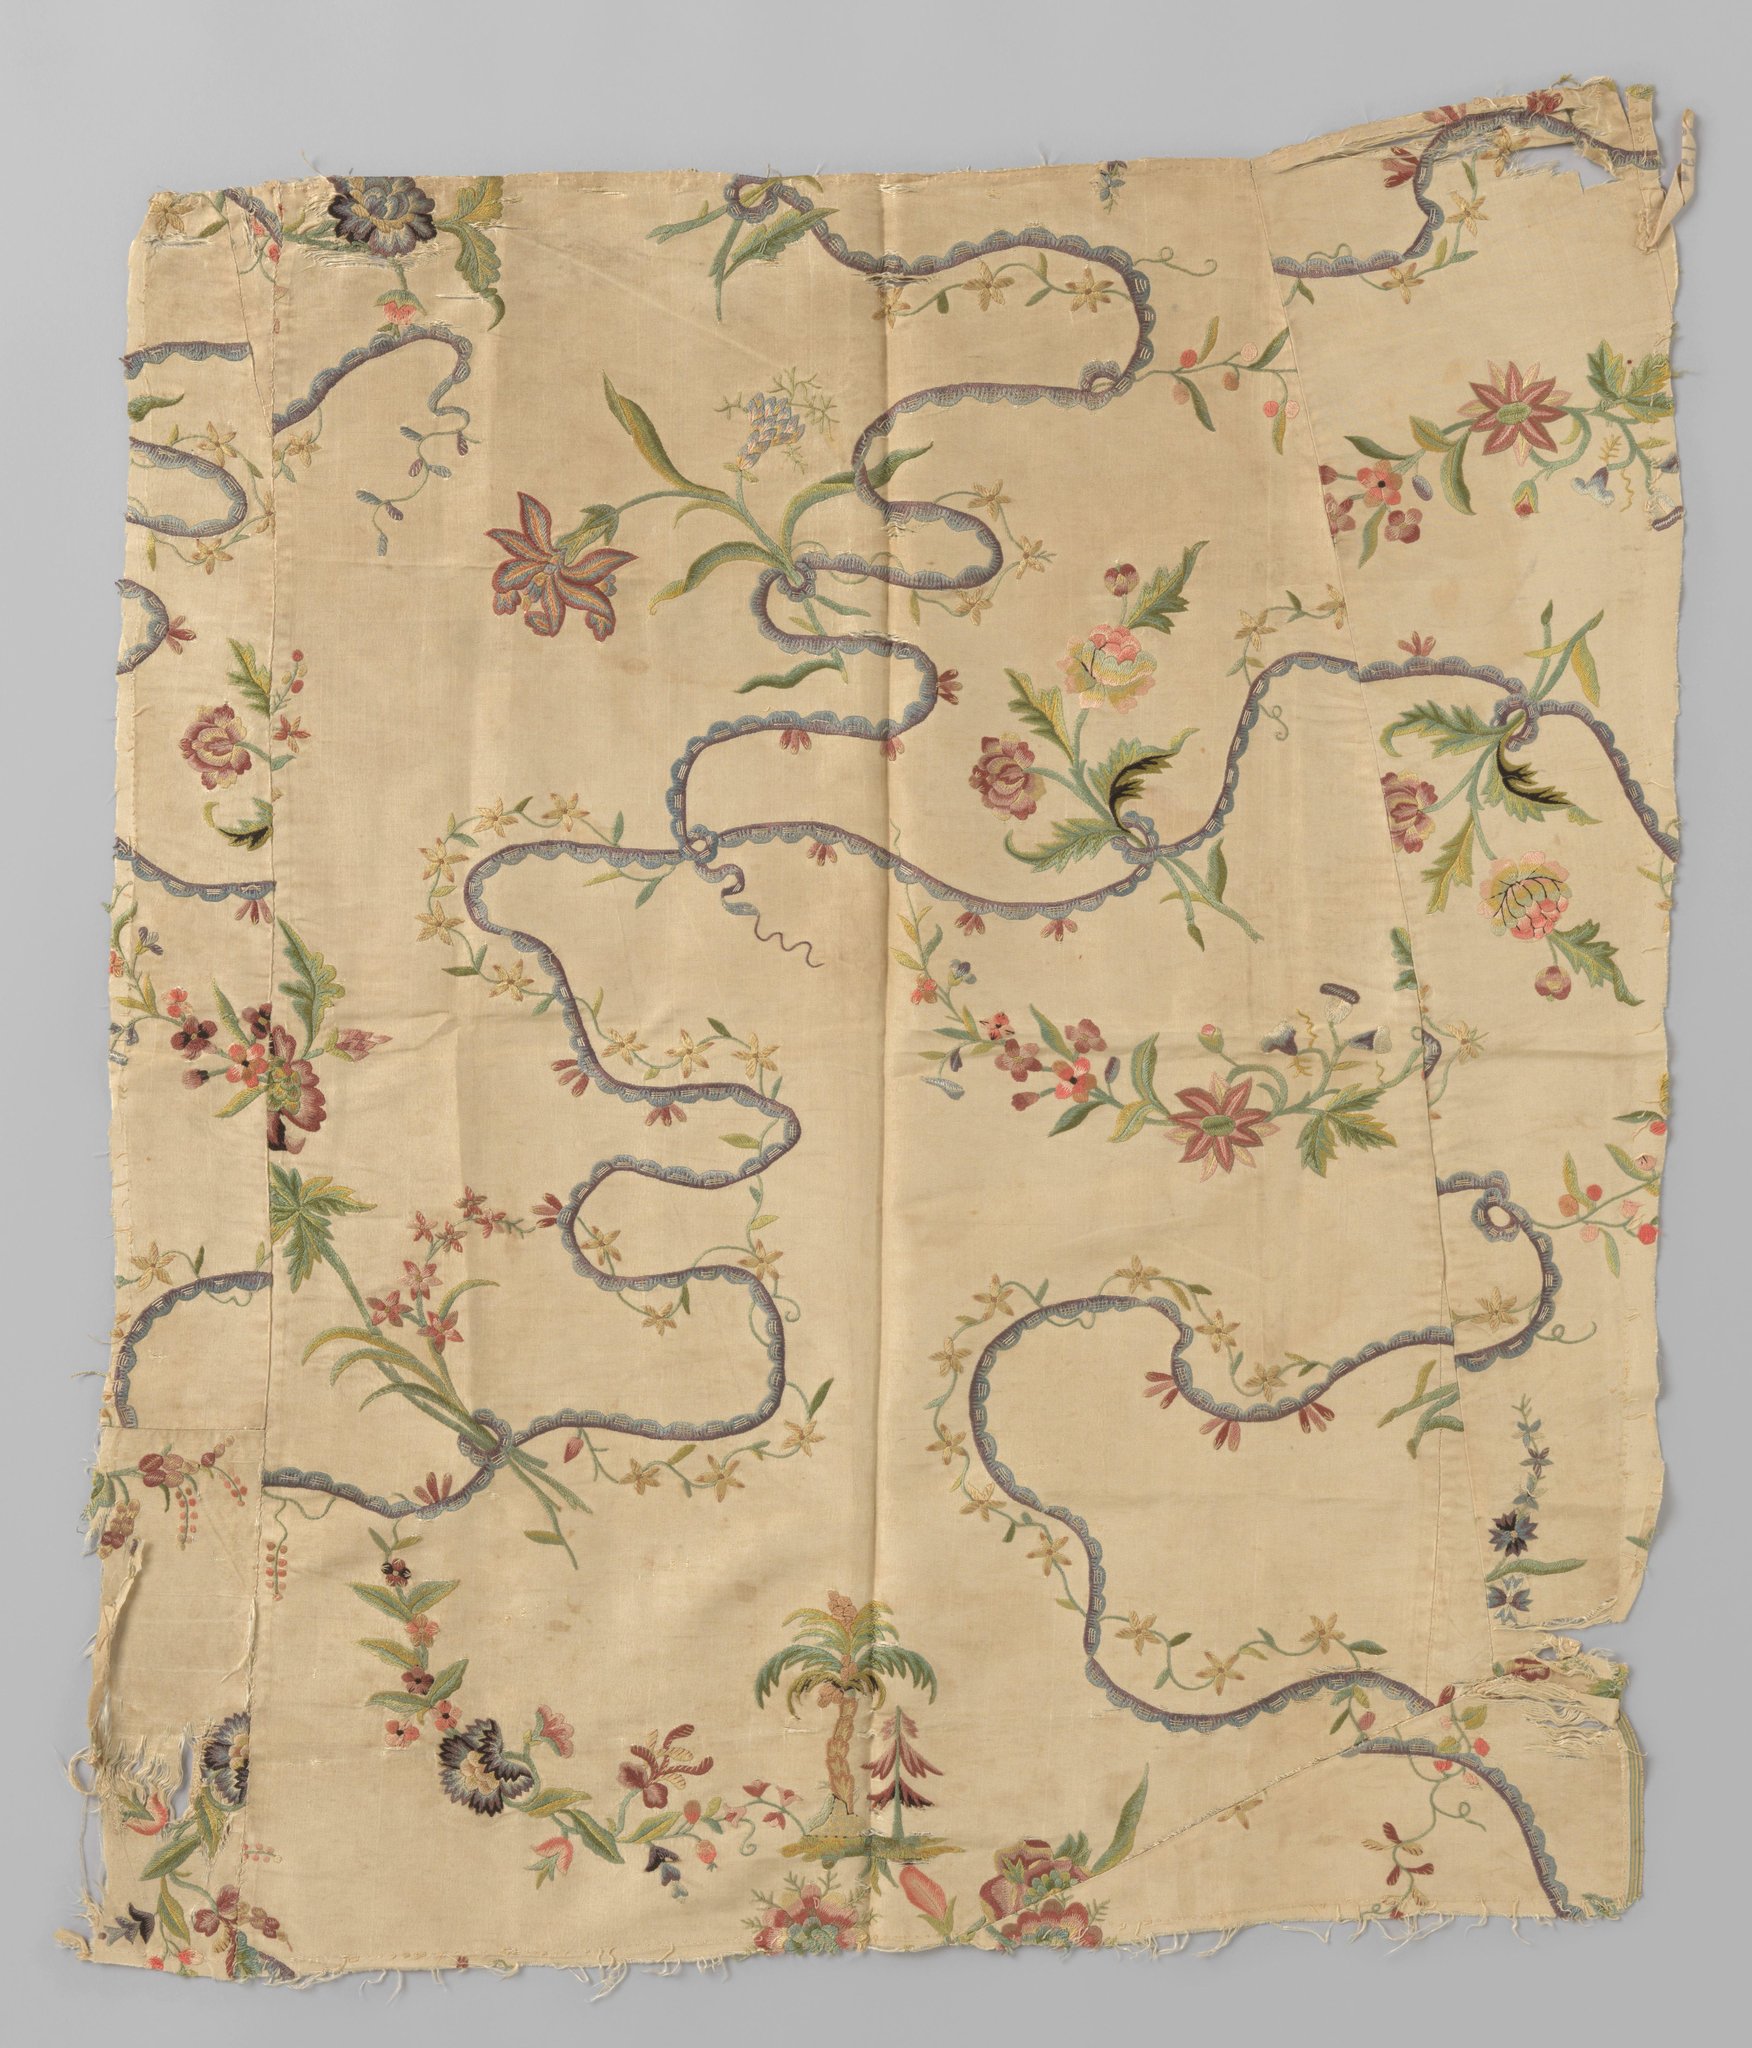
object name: upholstered wall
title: Fragment bespanning van crème-kleurige ripszijde met kleurig borduurwerk met grillig slingerende linten met o.a. palmbomen en loofhutten(?), takken en ranken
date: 1740-1760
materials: silk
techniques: embroidered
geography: france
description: Fragment bespanning van crème-kleurige ripszijde met kleurig borduursel van symmetrisch-breed en grillig slingerende, geschulpte linten van half lichtblauw, half paars. Op grote afstanden staan afwisselend een palmboom en een begroeide pergola (loofhutten?). Losse takken met genuanceerd gekleurde bloemen worden in een lus van de linten gebonden, terwijl dunnere ranken met fijne bloemen zich om de linten slingeren.